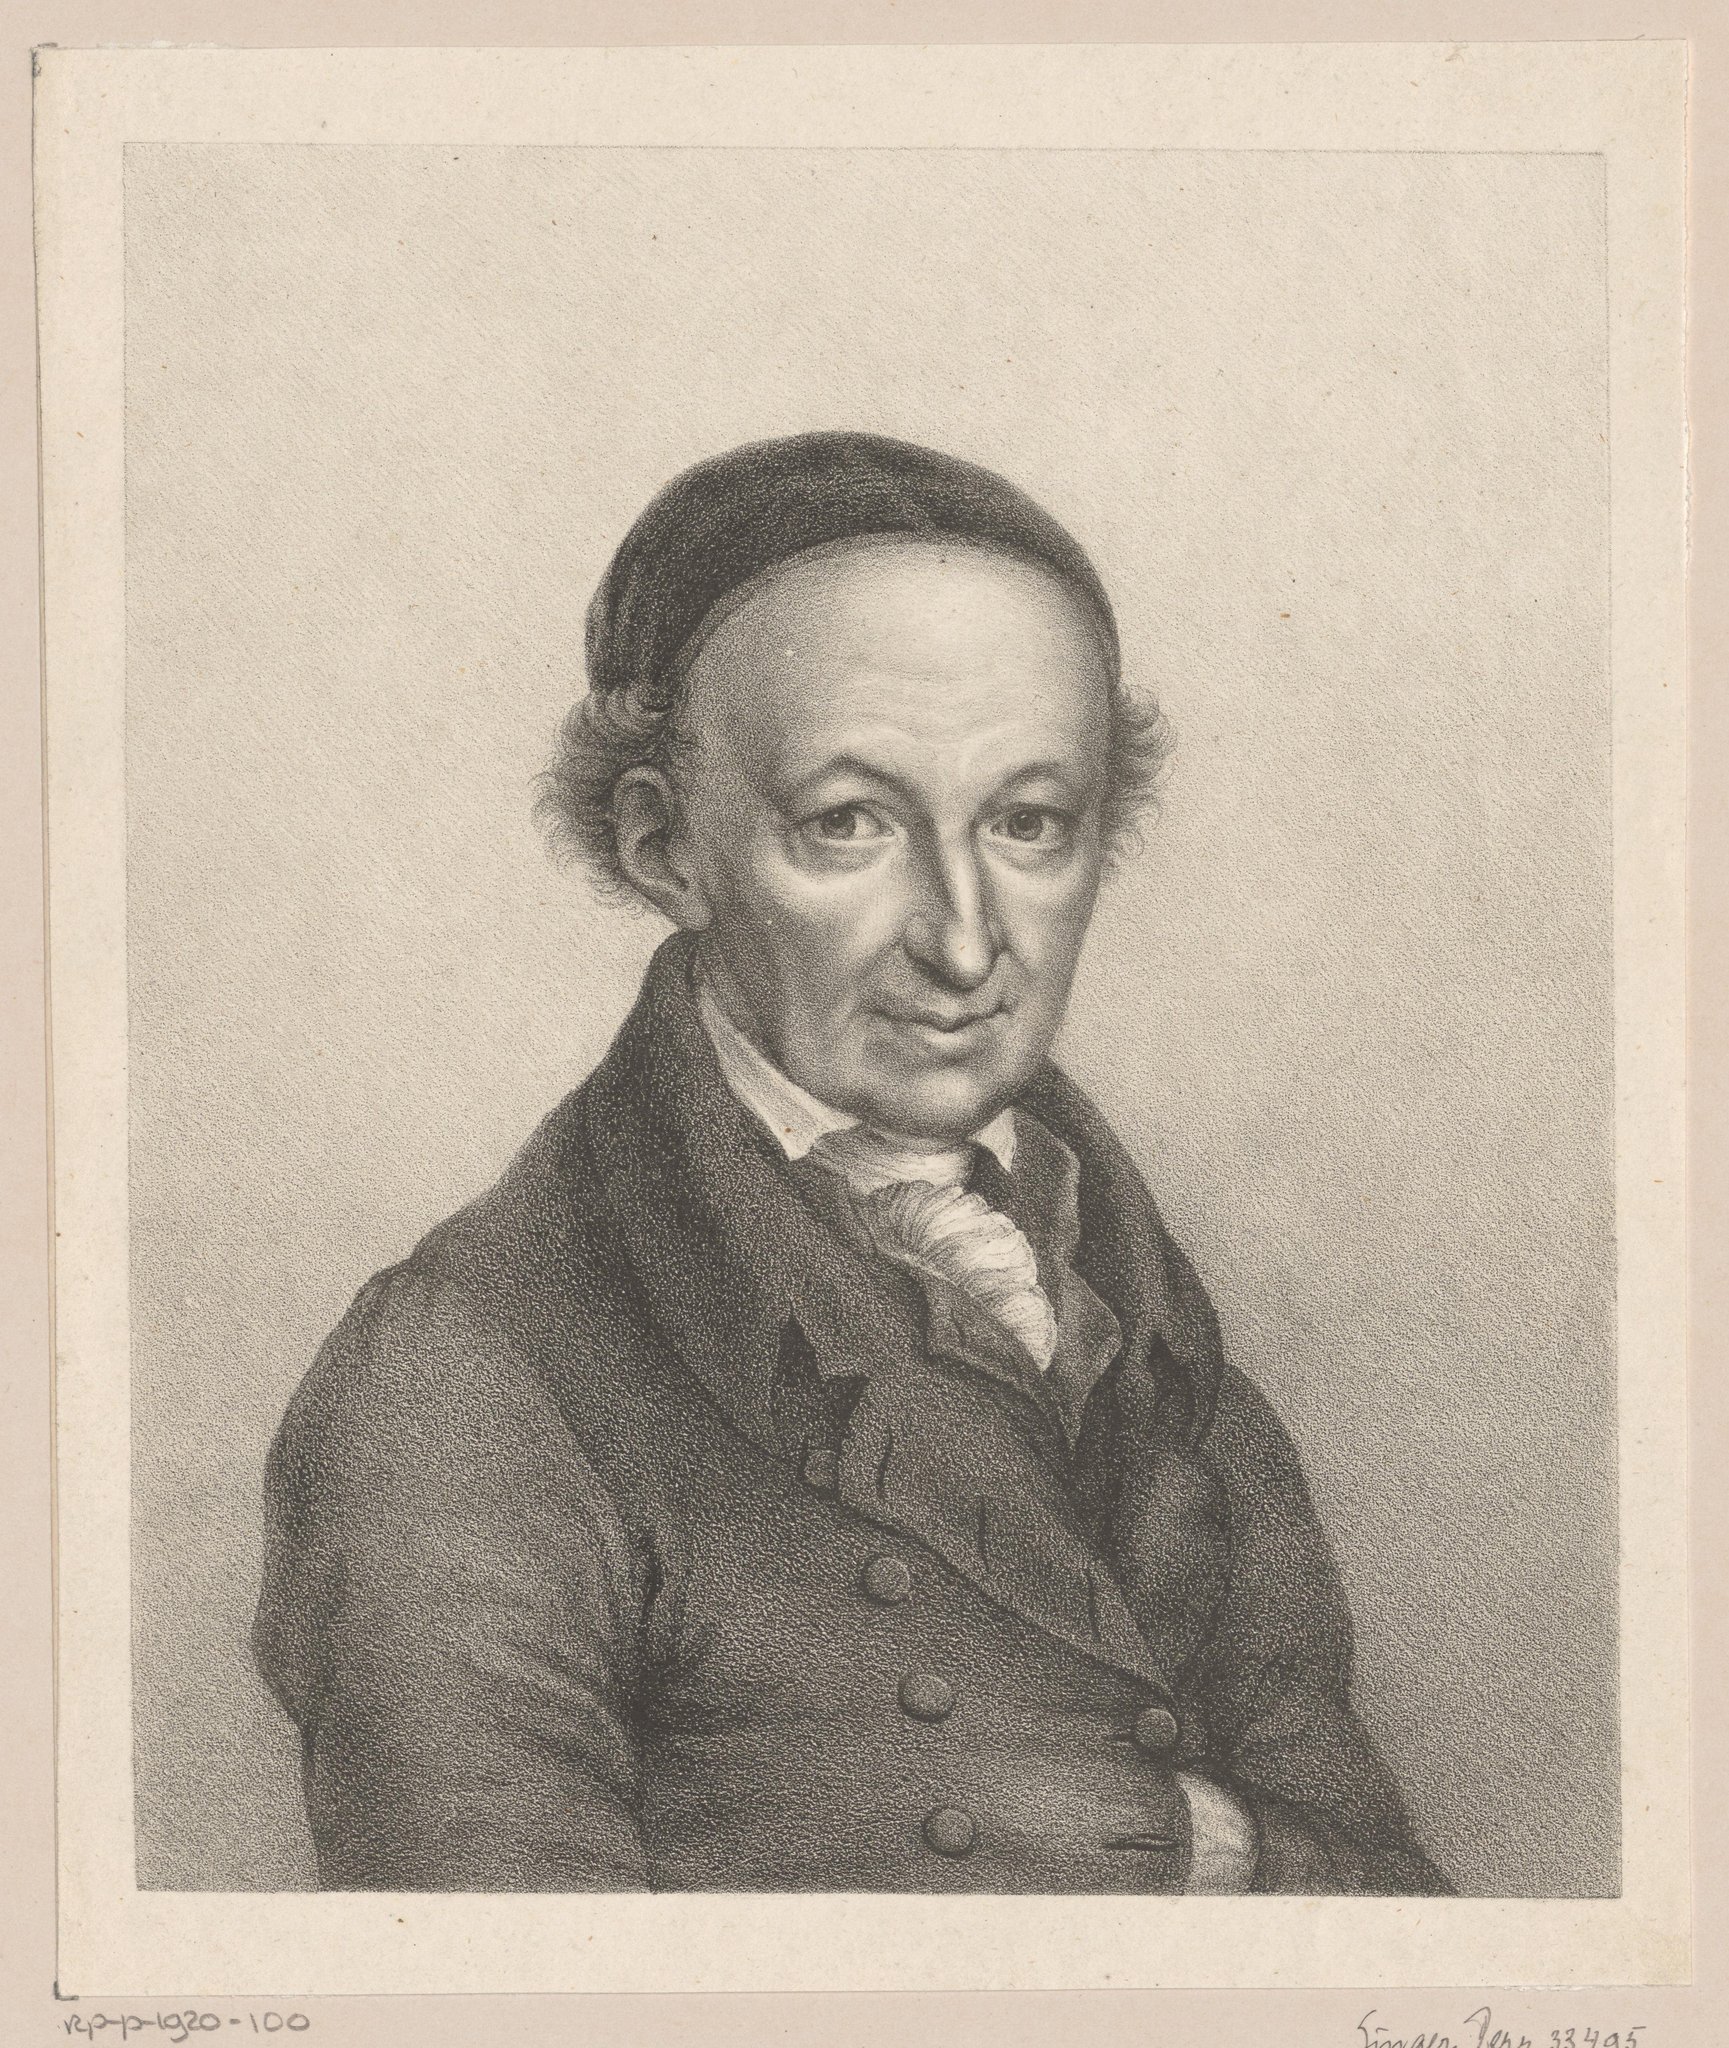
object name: print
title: Portret van Christoph Martin Wieland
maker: Anonymous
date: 1830-1899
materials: paper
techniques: lithograph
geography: germany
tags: publisher, christoph martin wieland, historical persons, writer, poet, author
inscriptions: collector's mark: Lugt 2228